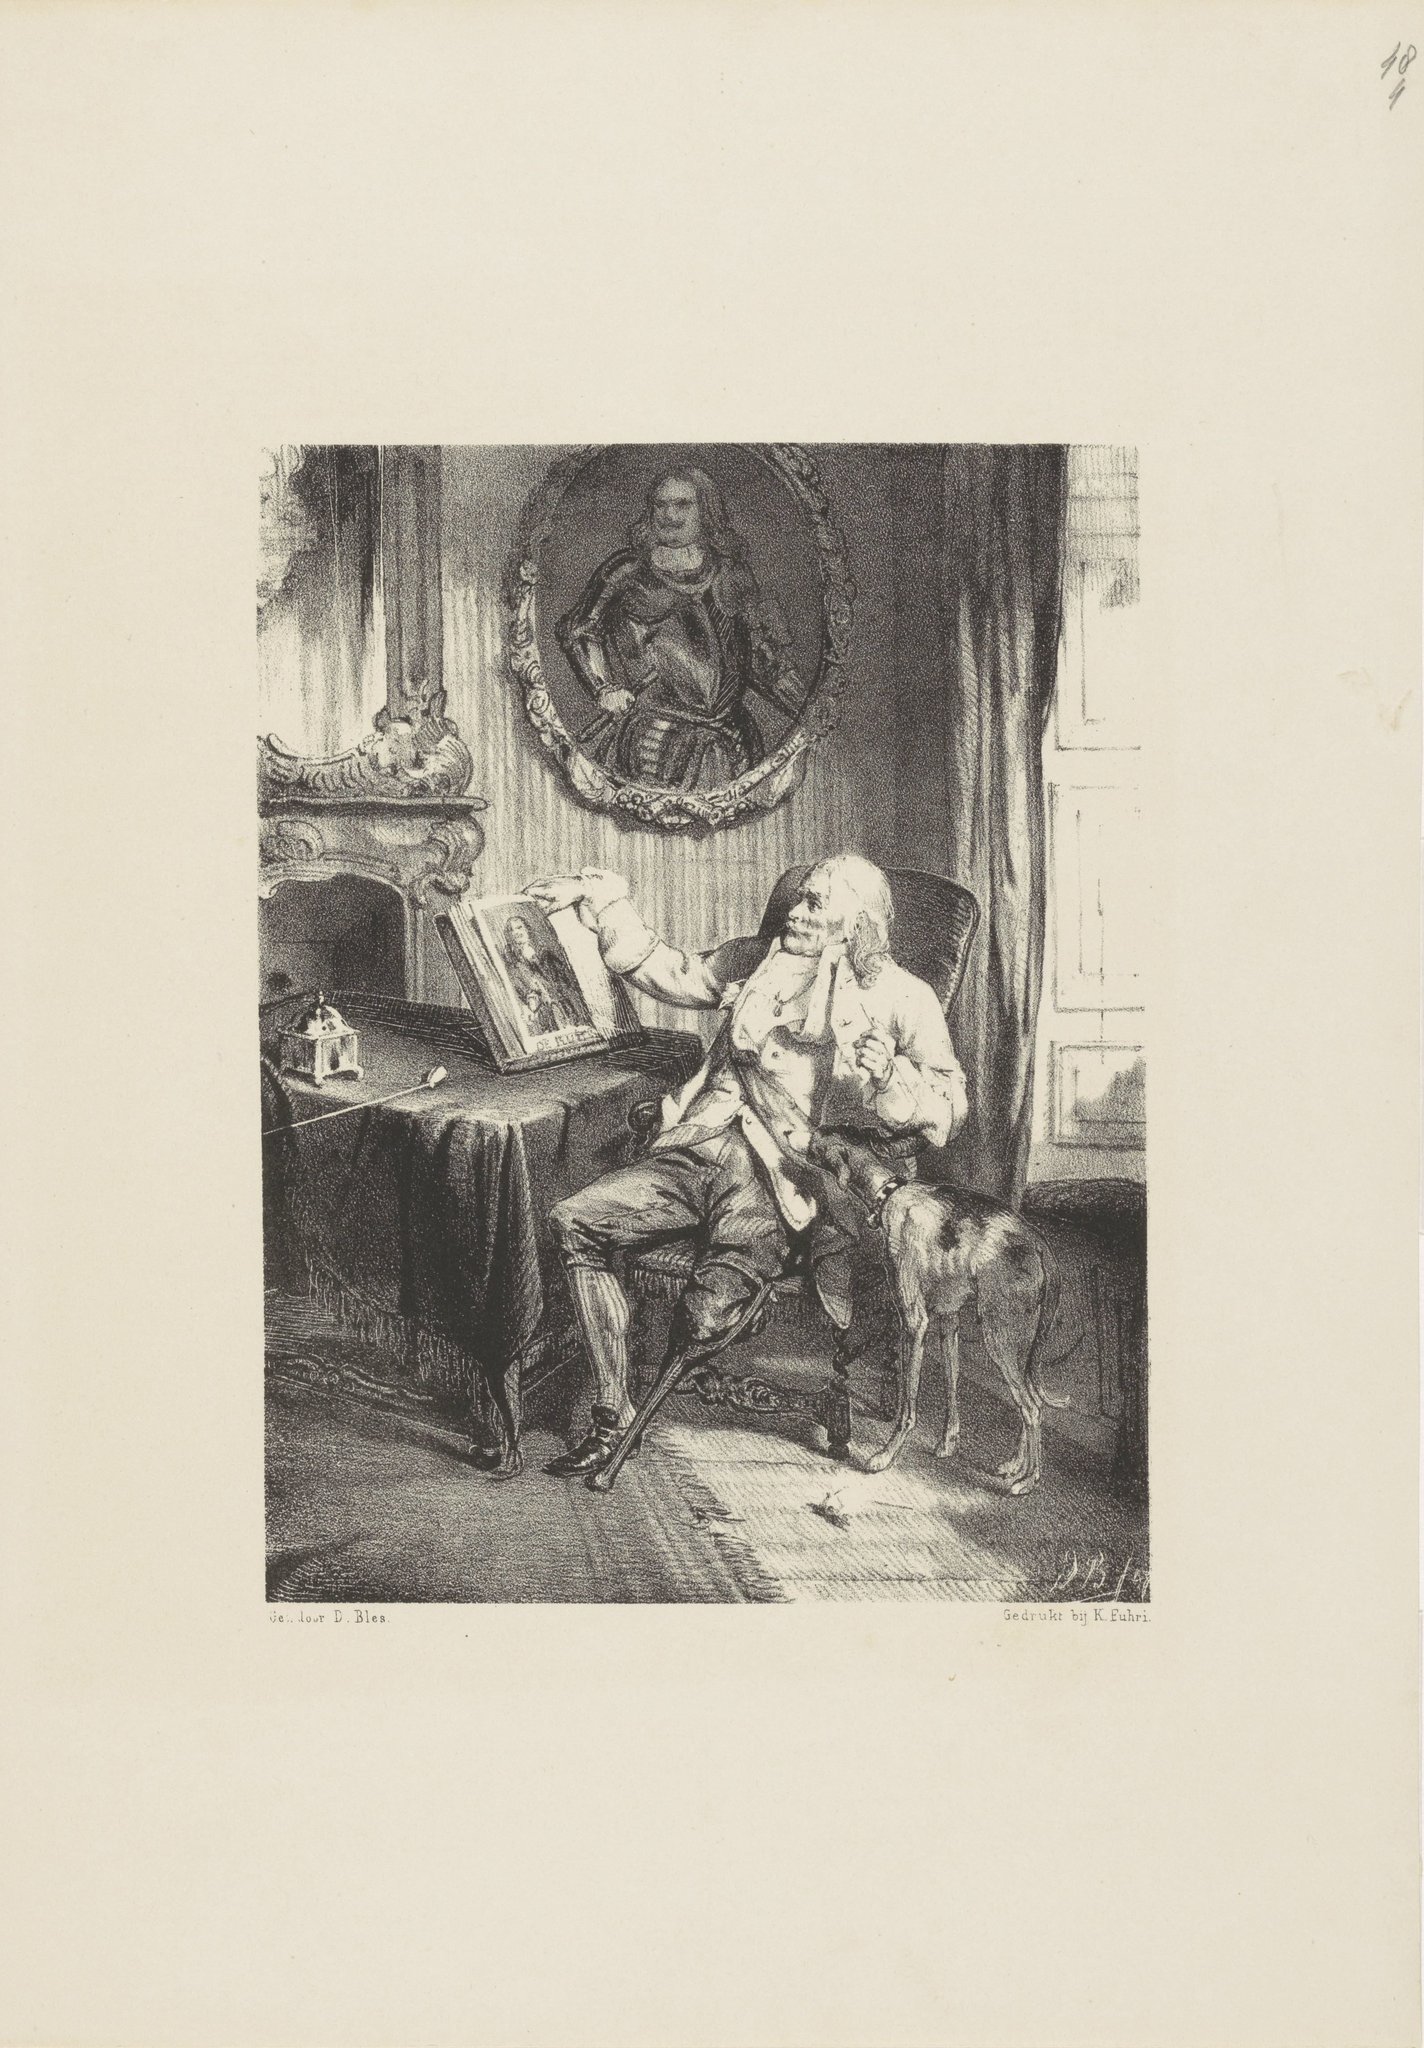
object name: print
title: Oude Michiel Adriaenszoon de Ruyter in een interieur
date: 1837-1853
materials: paper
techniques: lithograph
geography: the hague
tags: flushing, michiel adriaenszoon de ruyter, wooden leg, old man, reading a picture book, portrait, self-portrait of artist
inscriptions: collector's mark: Lugt 2228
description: Hij zit op een stoel aan tafel. In zijn linkerhand heeft hij een pijp, met zijn andere hand houdt hij een boek vast dat op tafel staat. Op de opengeslagen bladzijde staat een portret van hemzelf in jongere jaren. Achter hem aan de wand hangt een groot portret van hem. Hij heeft een houten been en naast hem staat een hond. Michiel Adriaenszoon de Ruyter overleed in 1676 nadat de wond aan zijn geamputeerde been geïnfecteerd was geraakt.